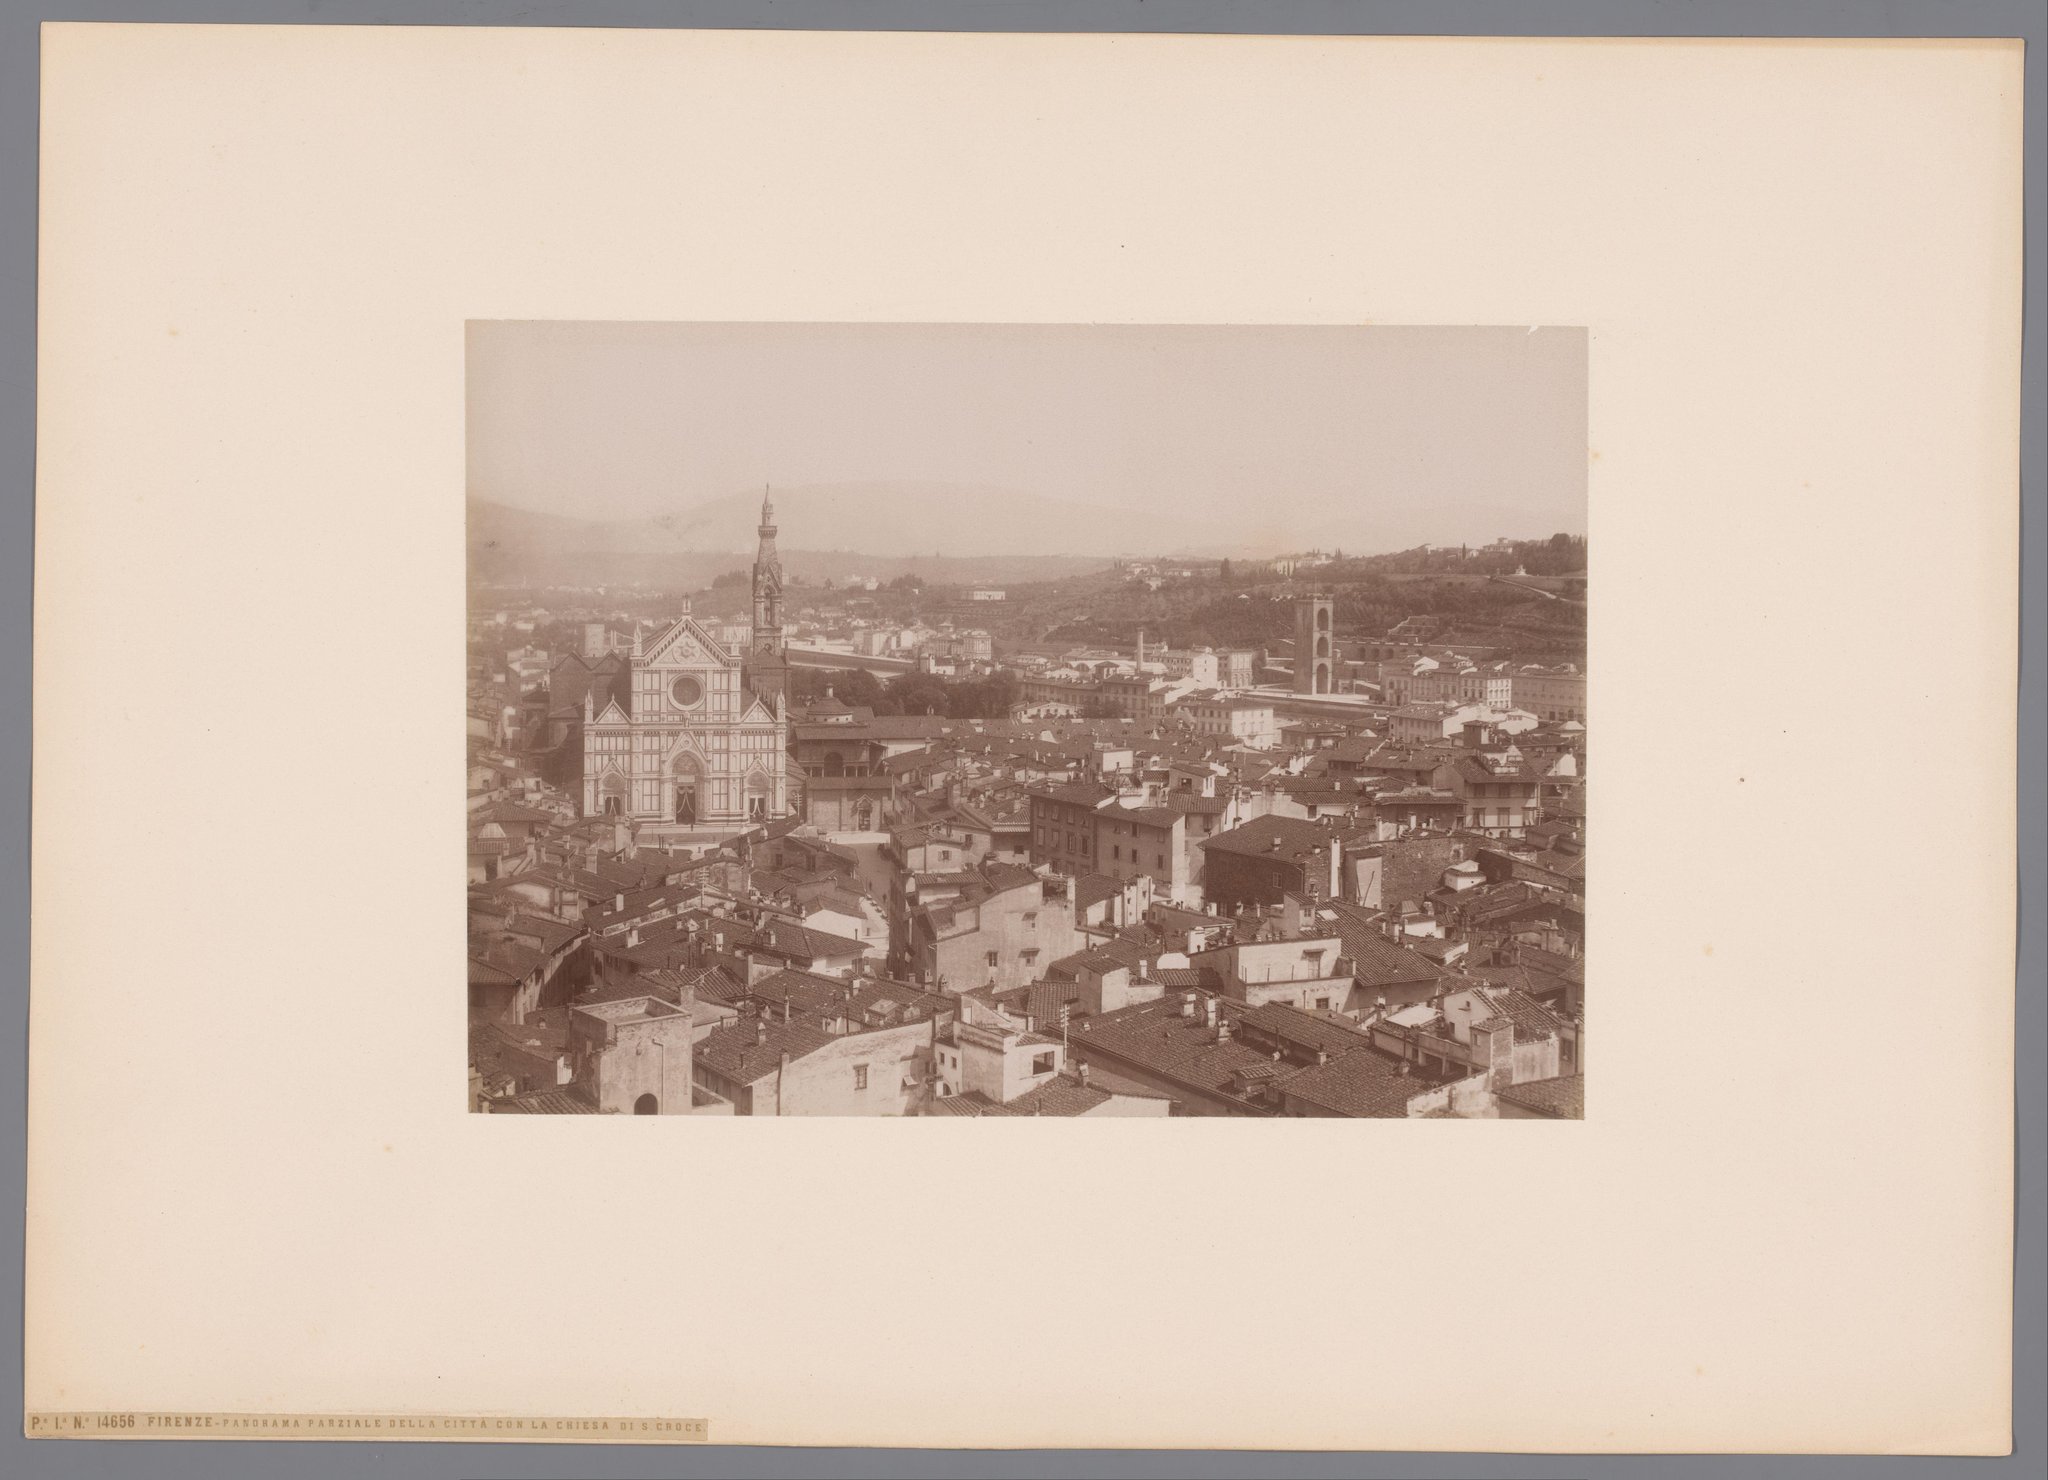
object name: photograph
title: Firenze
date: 1852-1890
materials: cardboard, paper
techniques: albumen print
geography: florence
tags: church (exterior), prospect of city, town panorama, silhouette of city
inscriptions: number: ‘Pe. Ia. No. 14656’